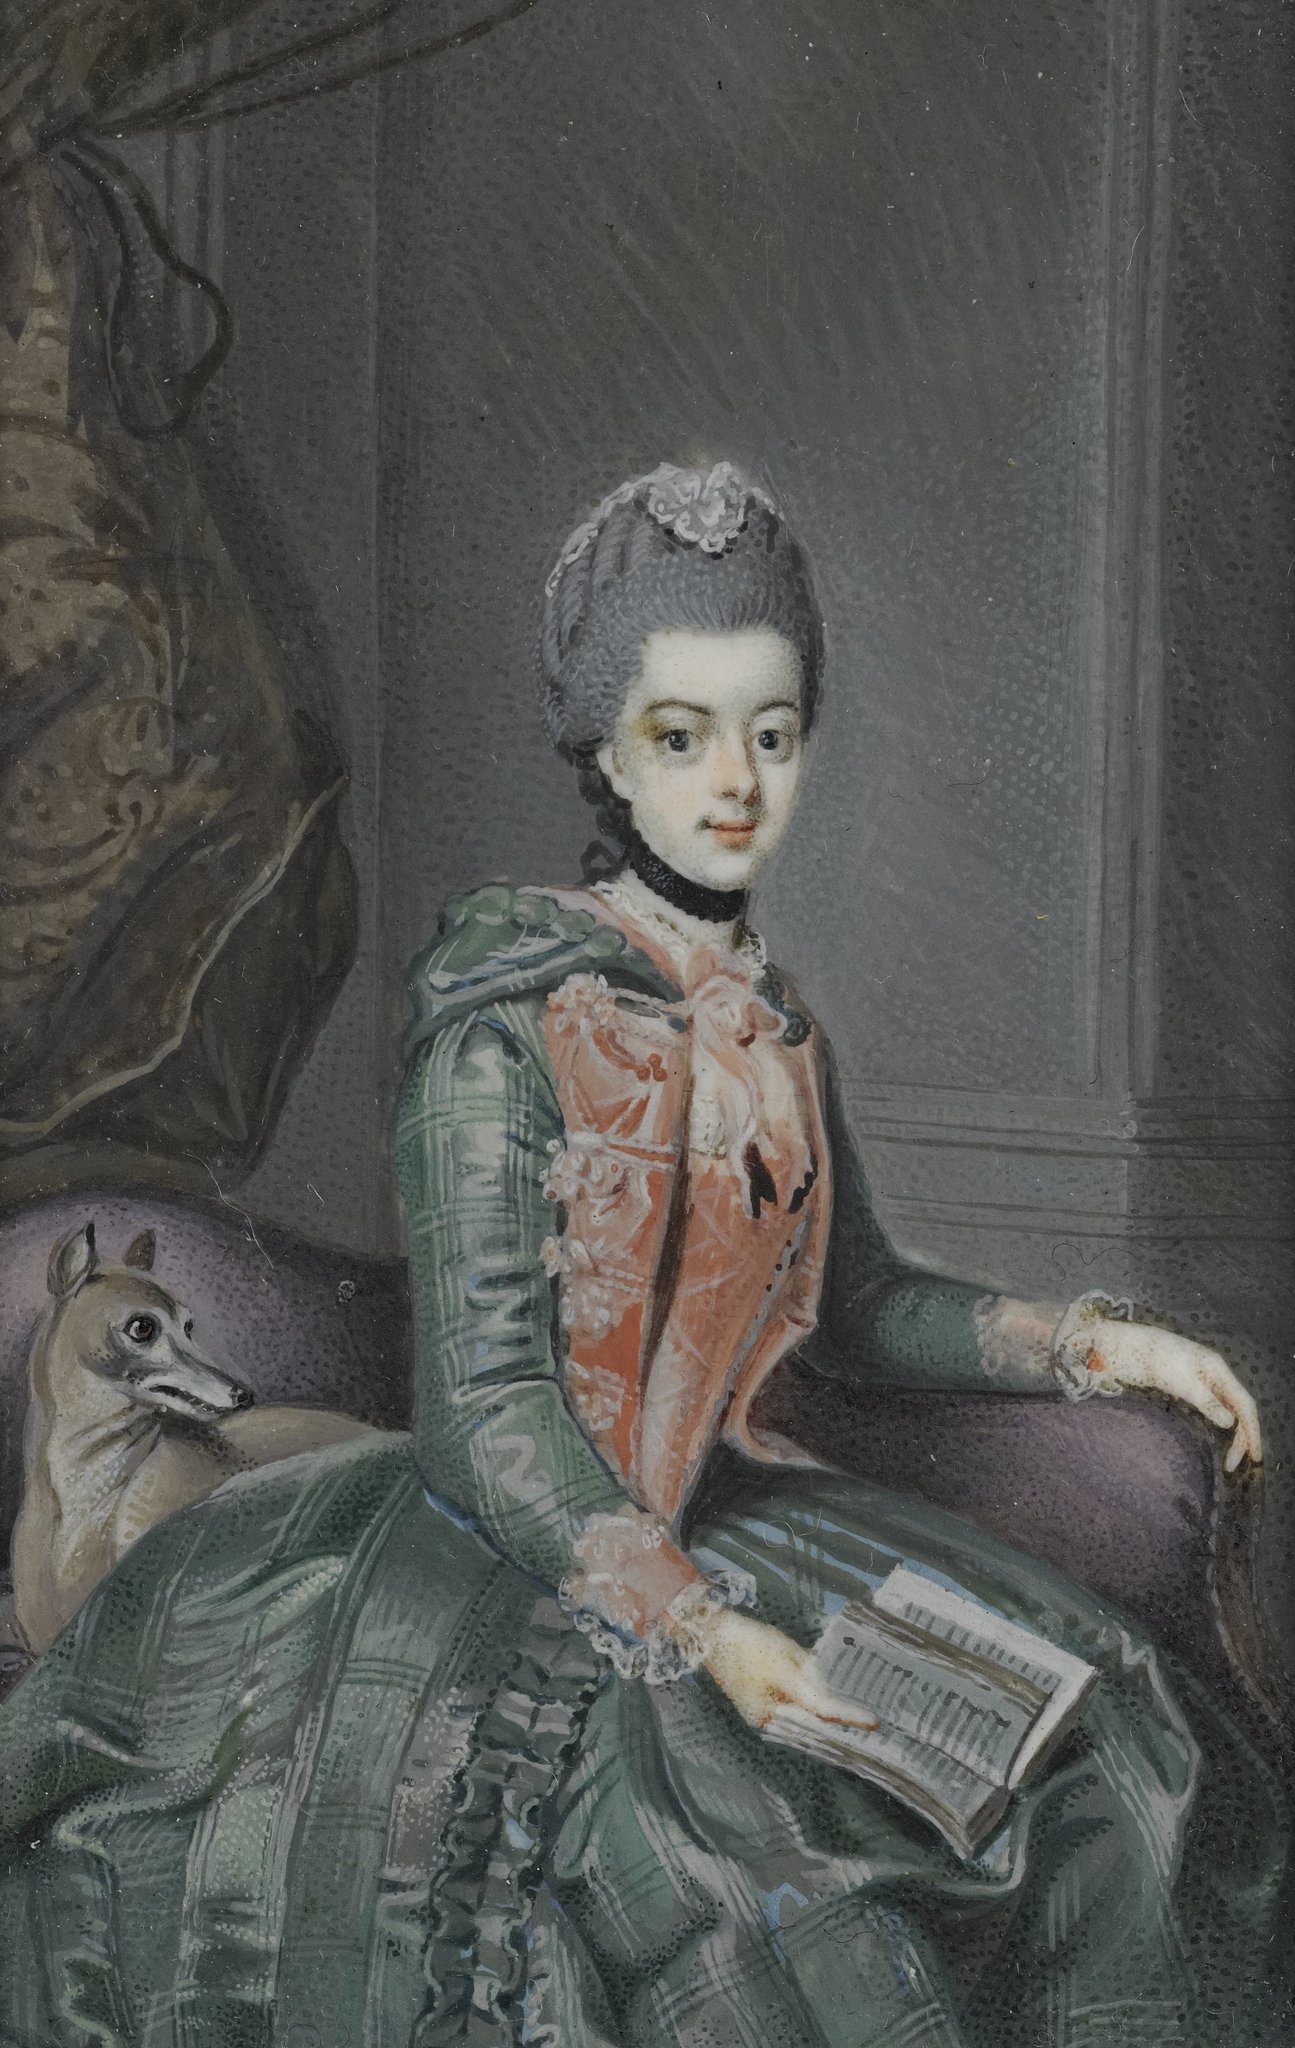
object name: painting, miniature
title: Frederika Sophia Wilhelmina (1751-1820), prinses van Pruisen. Echtgenote van prins Willem V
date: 1770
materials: ivory, wood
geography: netherlands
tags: berlin, painter, draughtsman, wilhelmina of prussia (princess of orange), historical persons - bb - woman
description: Wilhelmina of Prussia, wife of William V.